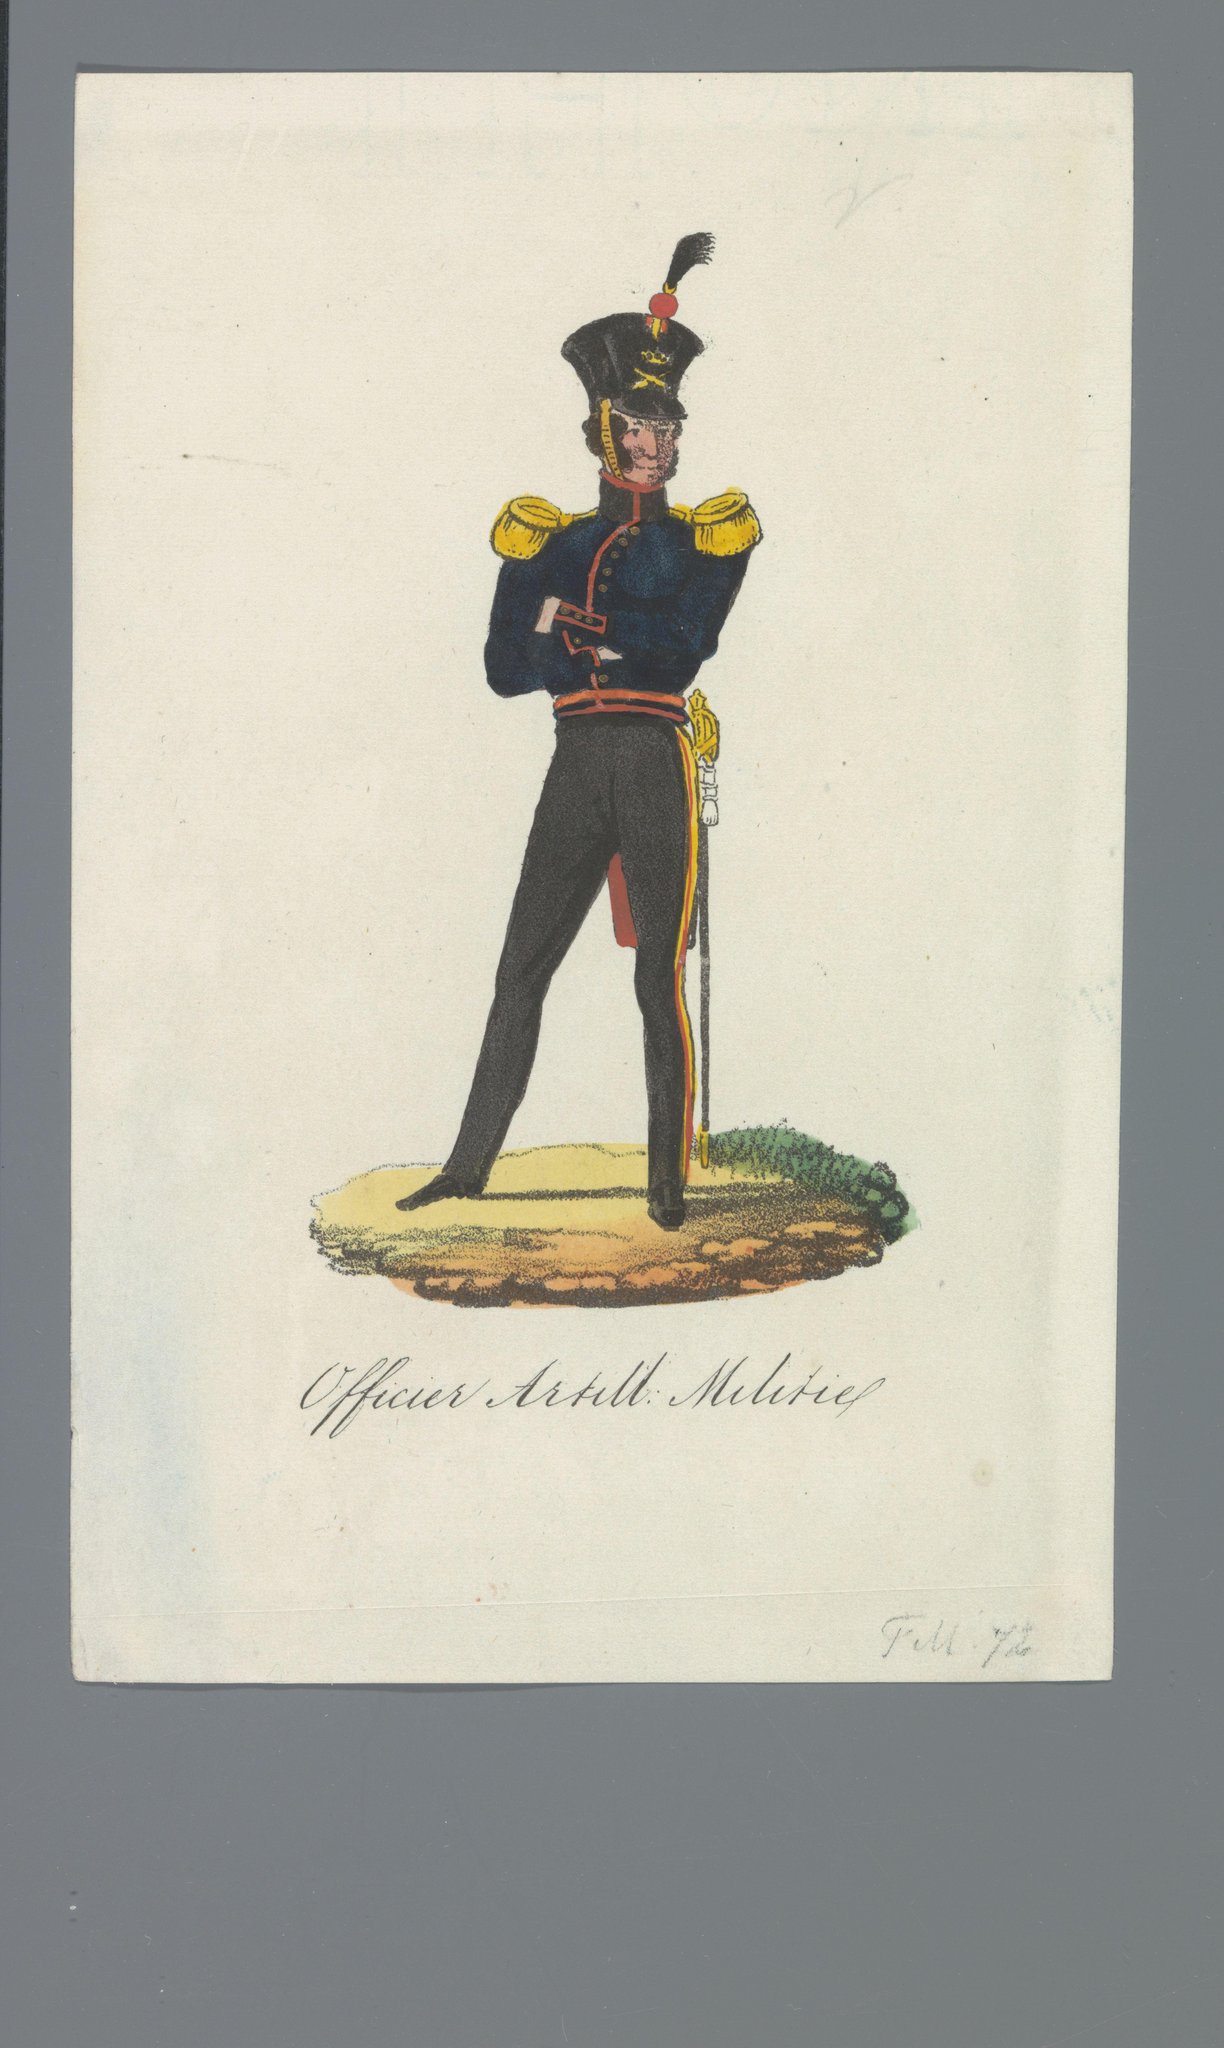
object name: costume print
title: Officier Artill: Militie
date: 1835-1850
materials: paper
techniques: hand coloring, lithograph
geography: netherlands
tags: (military) uniforms, clothes, costume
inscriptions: collector's mark: Lugt 2228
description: Een staande officier van de Militie-Artillerie. Onderdeel van een serie van 157 losse bladen met Nederlandse militaire uniformen in de jaren 1830-1832.